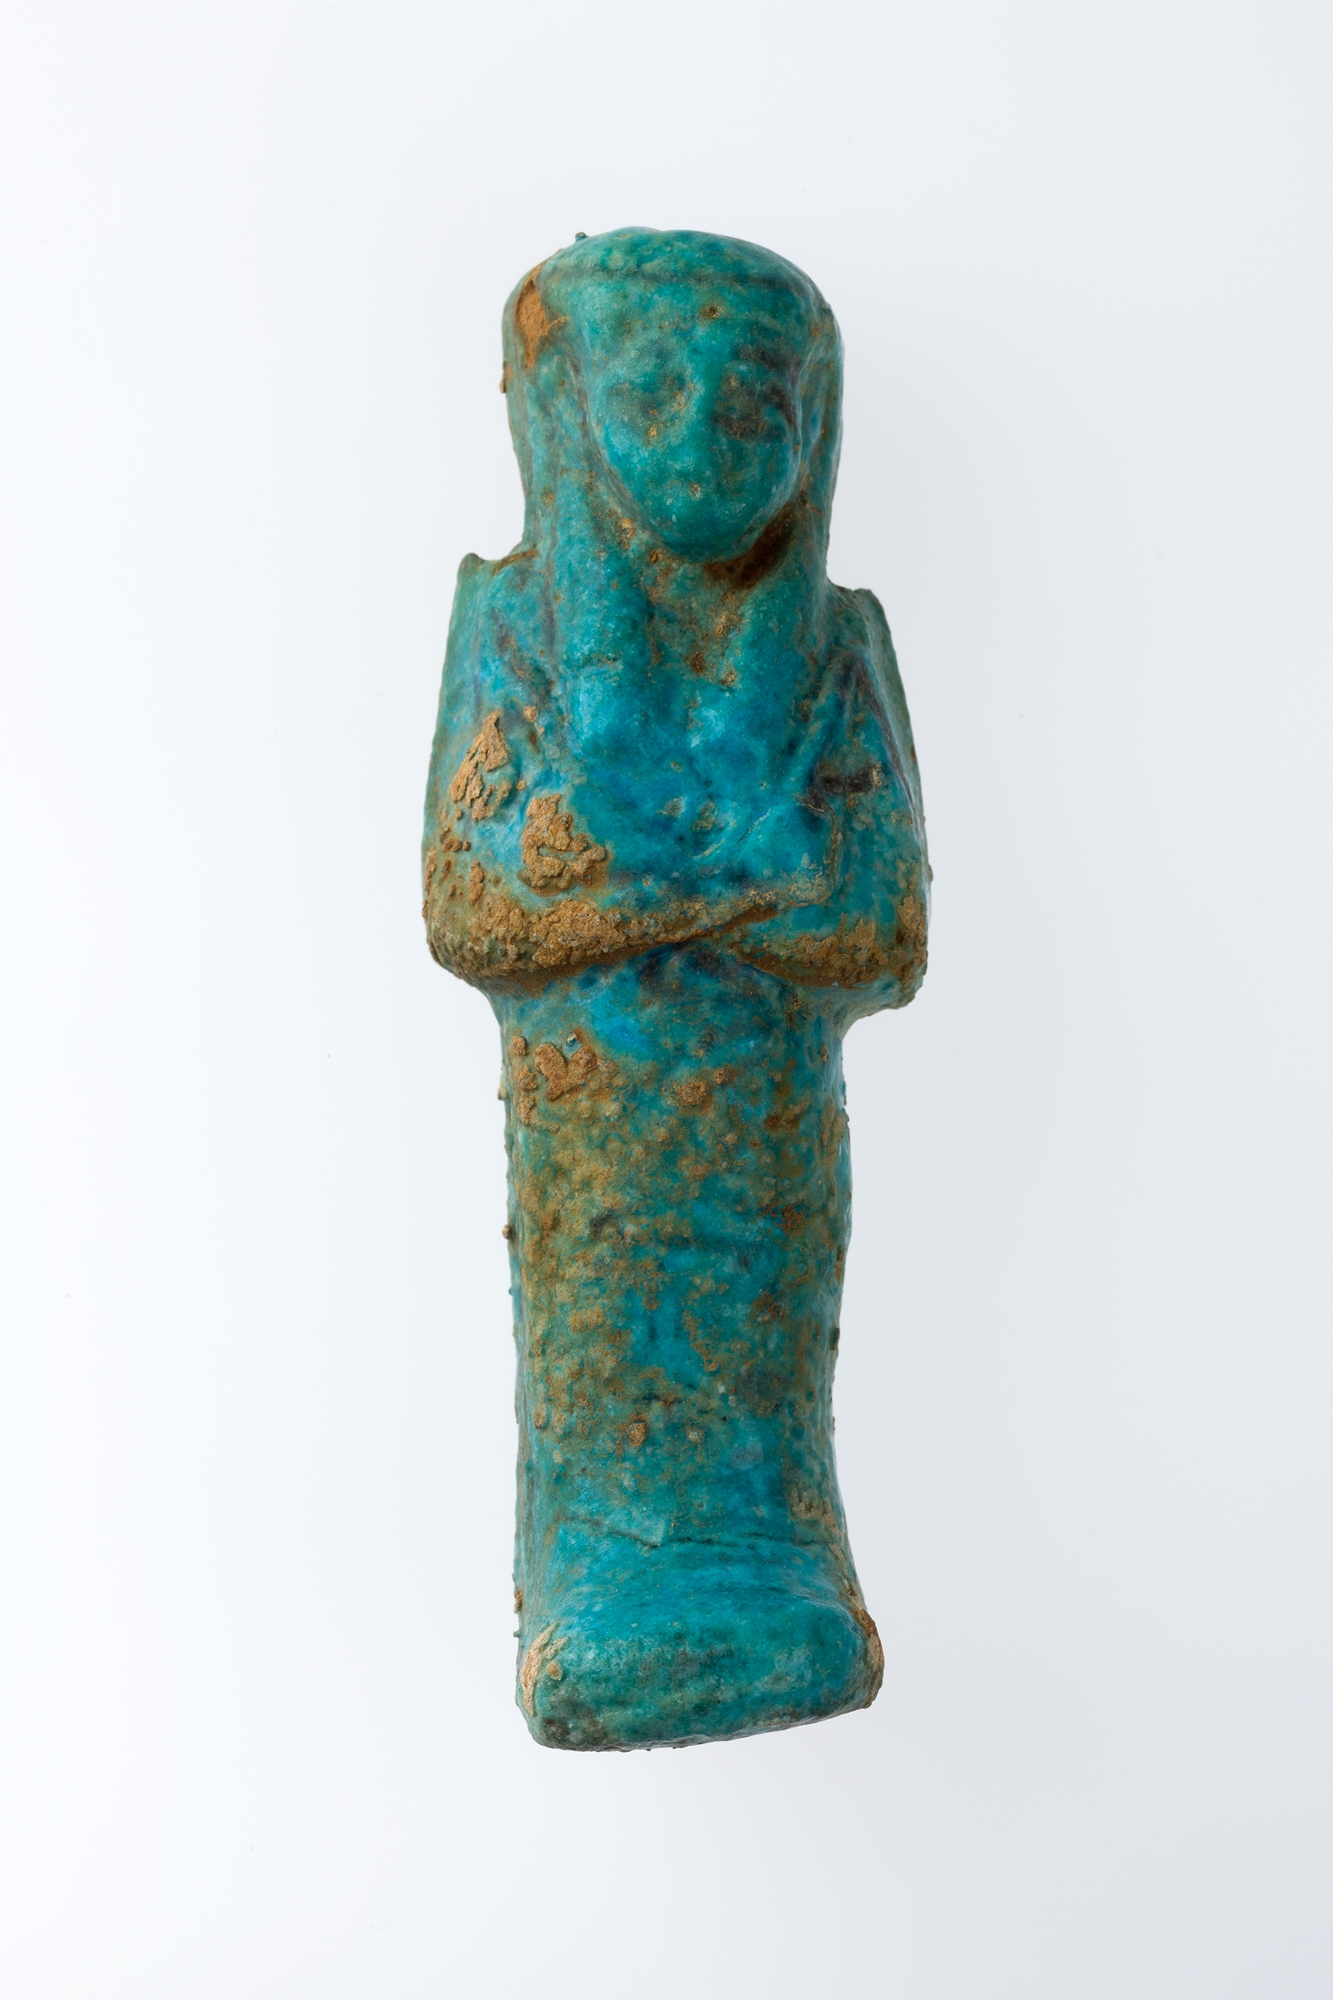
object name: shabti, henettawy c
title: Worker Shabti of Henettawy (C), Daughter of Isetemkheb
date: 990-970 BCE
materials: faience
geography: egypt